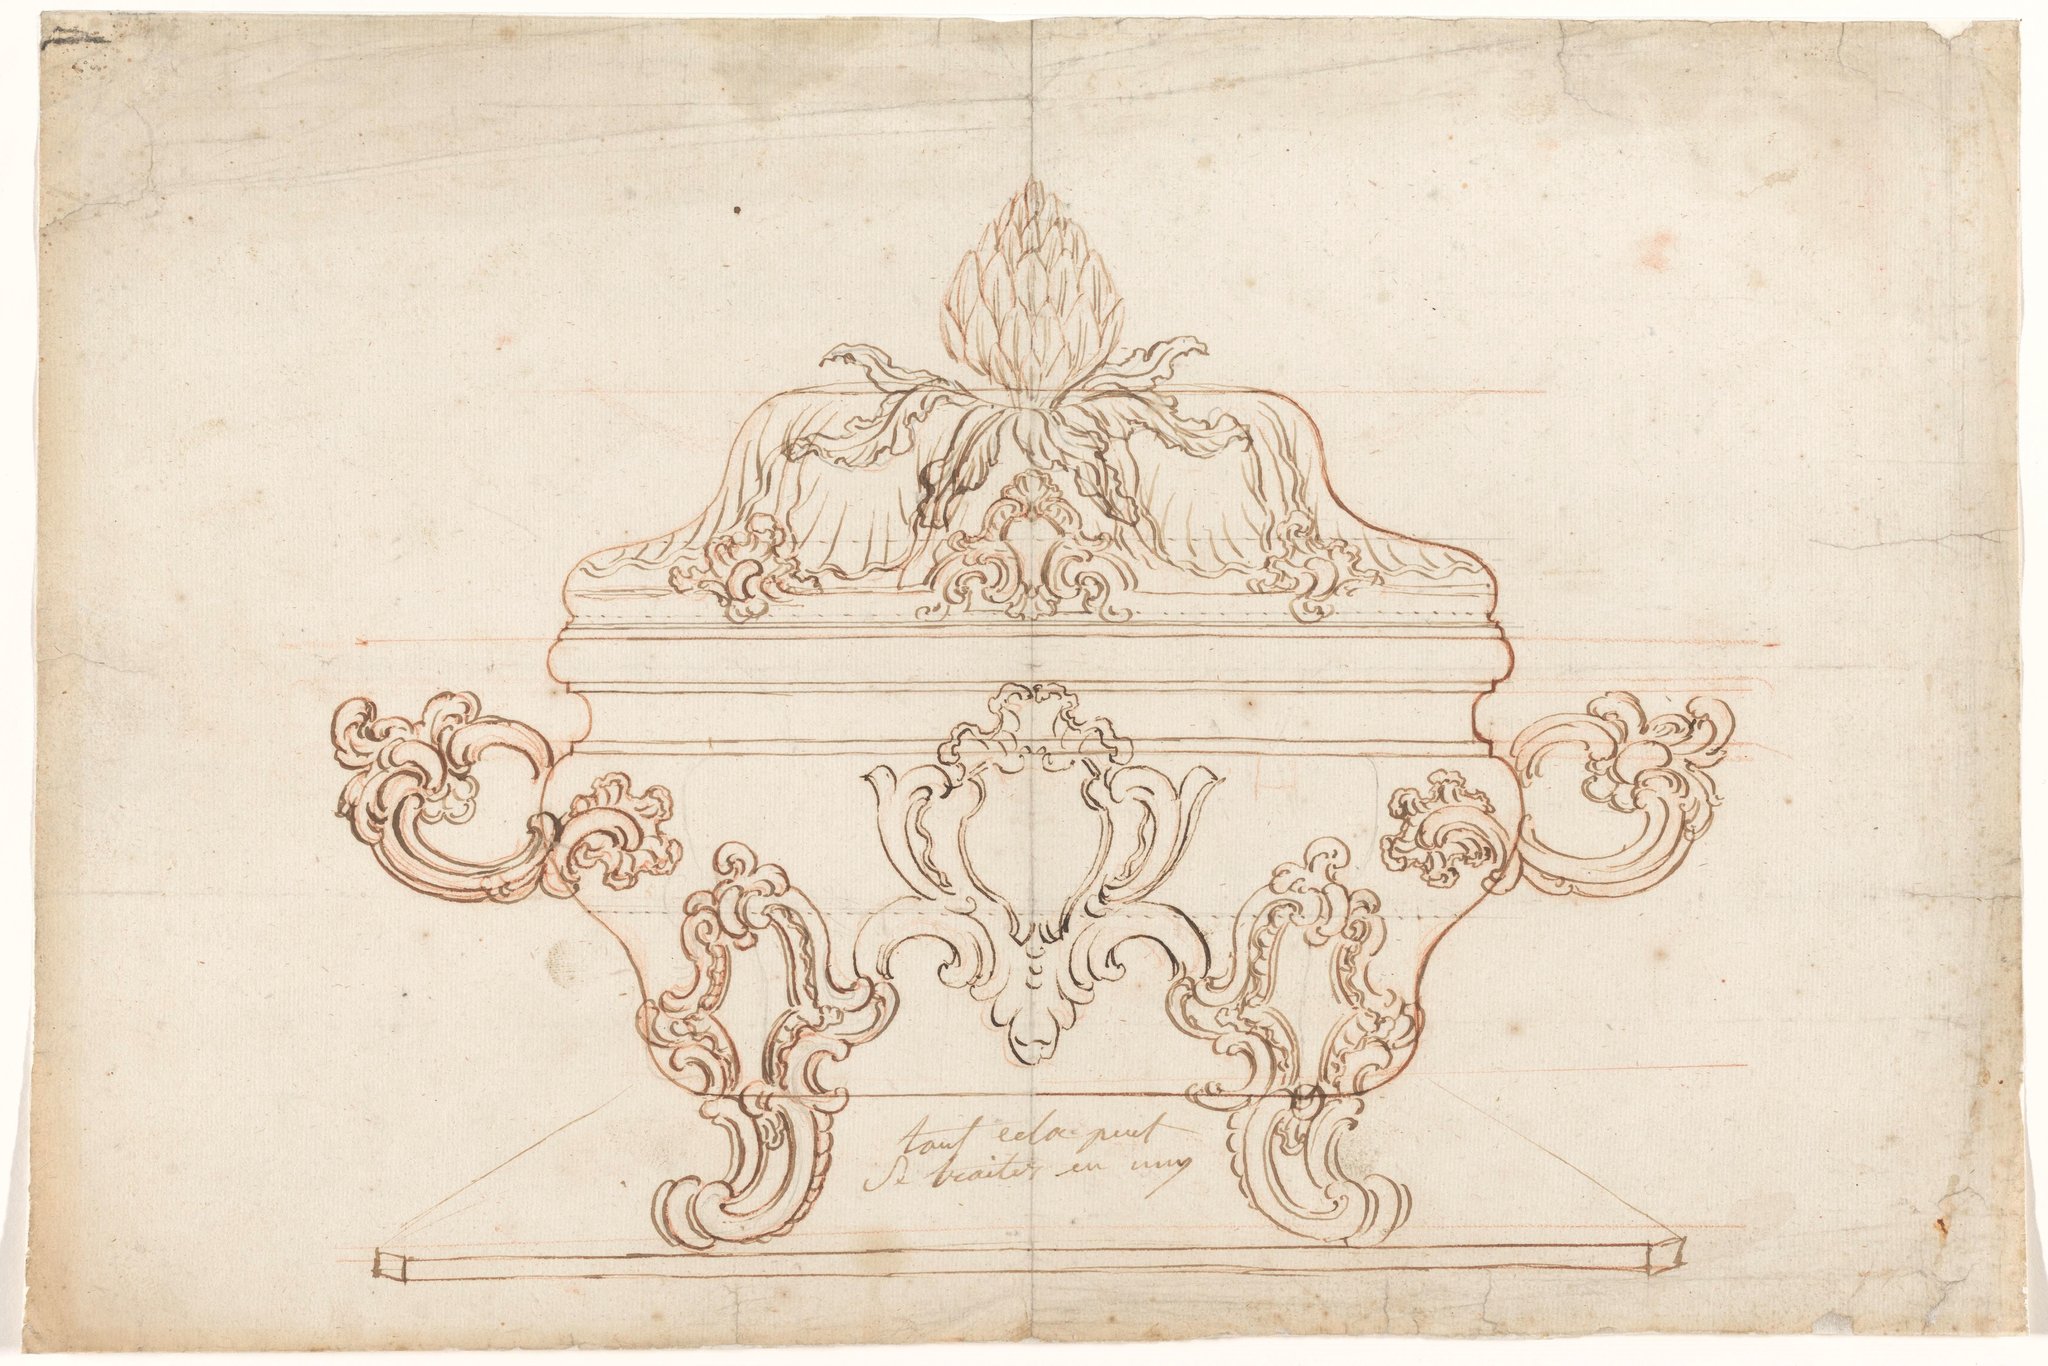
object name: drawing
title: Ovale terrine met deksel dat door een artisjok wordt bekroond, staande op een dunne plaat met afgeschuinde hoeken.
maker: Anonymous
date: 1750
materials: chalk, graphite, ink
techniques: drawing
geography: france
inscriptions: inscription: ‘tout cela peut se traiter en uny’, watermark: ‘PC ter weerszijden van slang [?]’